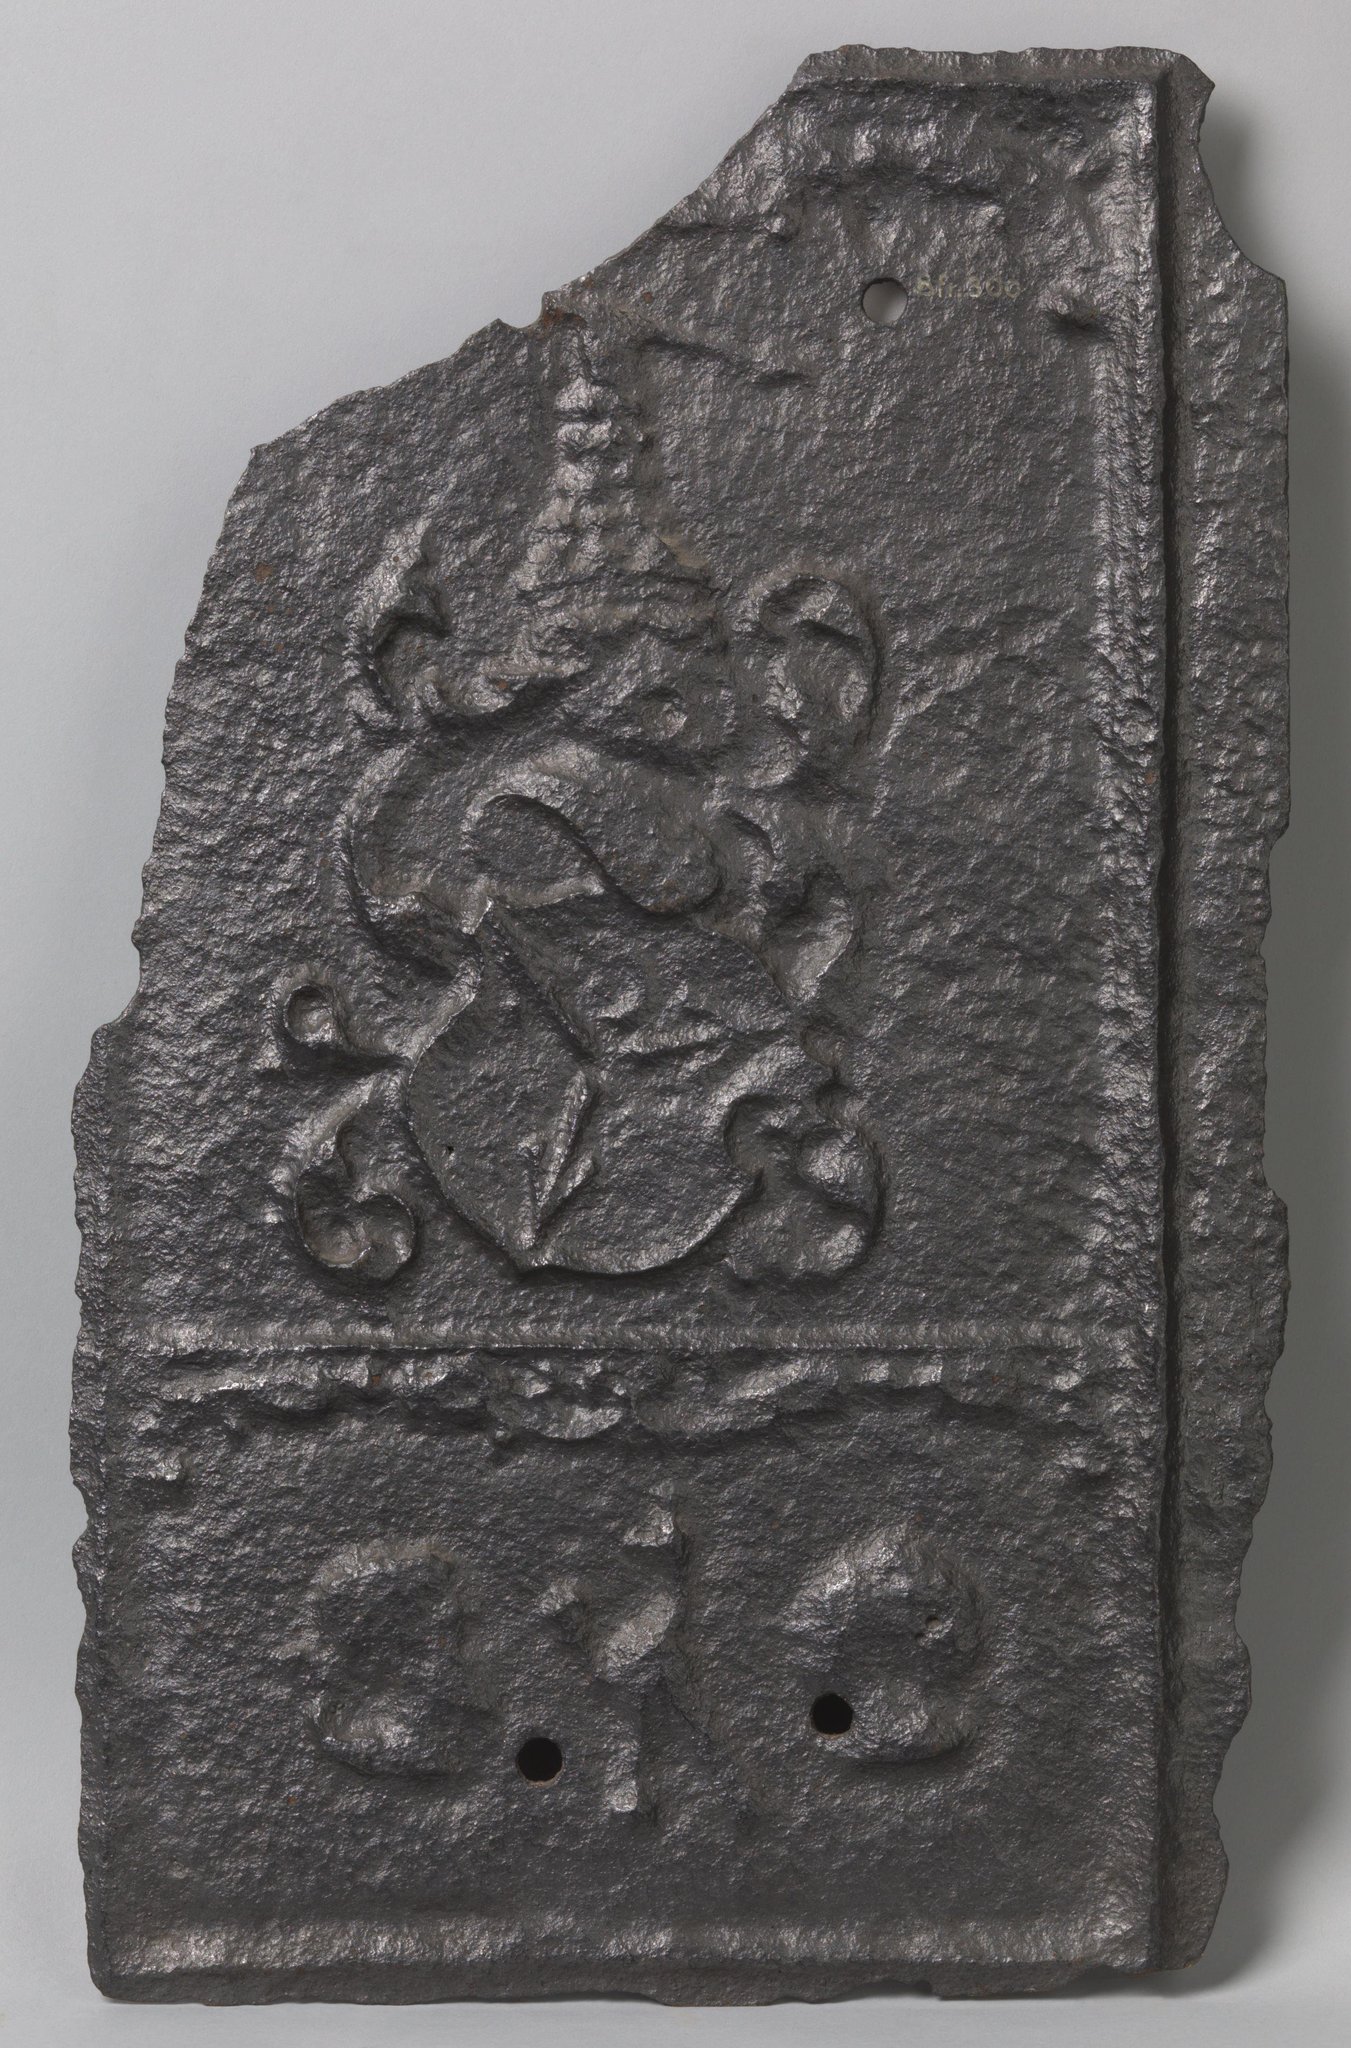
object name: stove plate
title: Kachelplaat met een wapenschild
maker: Anonymous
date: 1525-1575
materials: iron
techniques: casting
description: Kachelplaat van gietijzer, verdeeld in twee zones. In de bovenste zone is een wapenschild afgebeeld met daarop drie pijlen, die vanuit het midden naar buiten wijzen. Daarboven een heraldische helm. De onderste zone twee bustes en profil met daartussen een pauw.